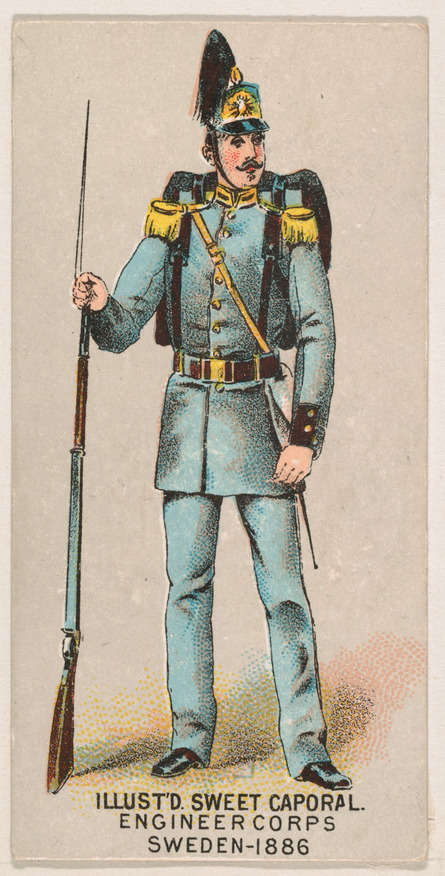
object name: print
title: Engineer Corps, Sweden, 1886, from the Military Series (N224) issued by Kinney Tobacco Company to promote Sweet Caporal Cigarettes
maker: kinney brothers tobacco company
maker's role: publisher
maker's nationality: american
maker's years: 1869-2011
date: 1888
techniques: color lithograph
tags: military,firearms,men